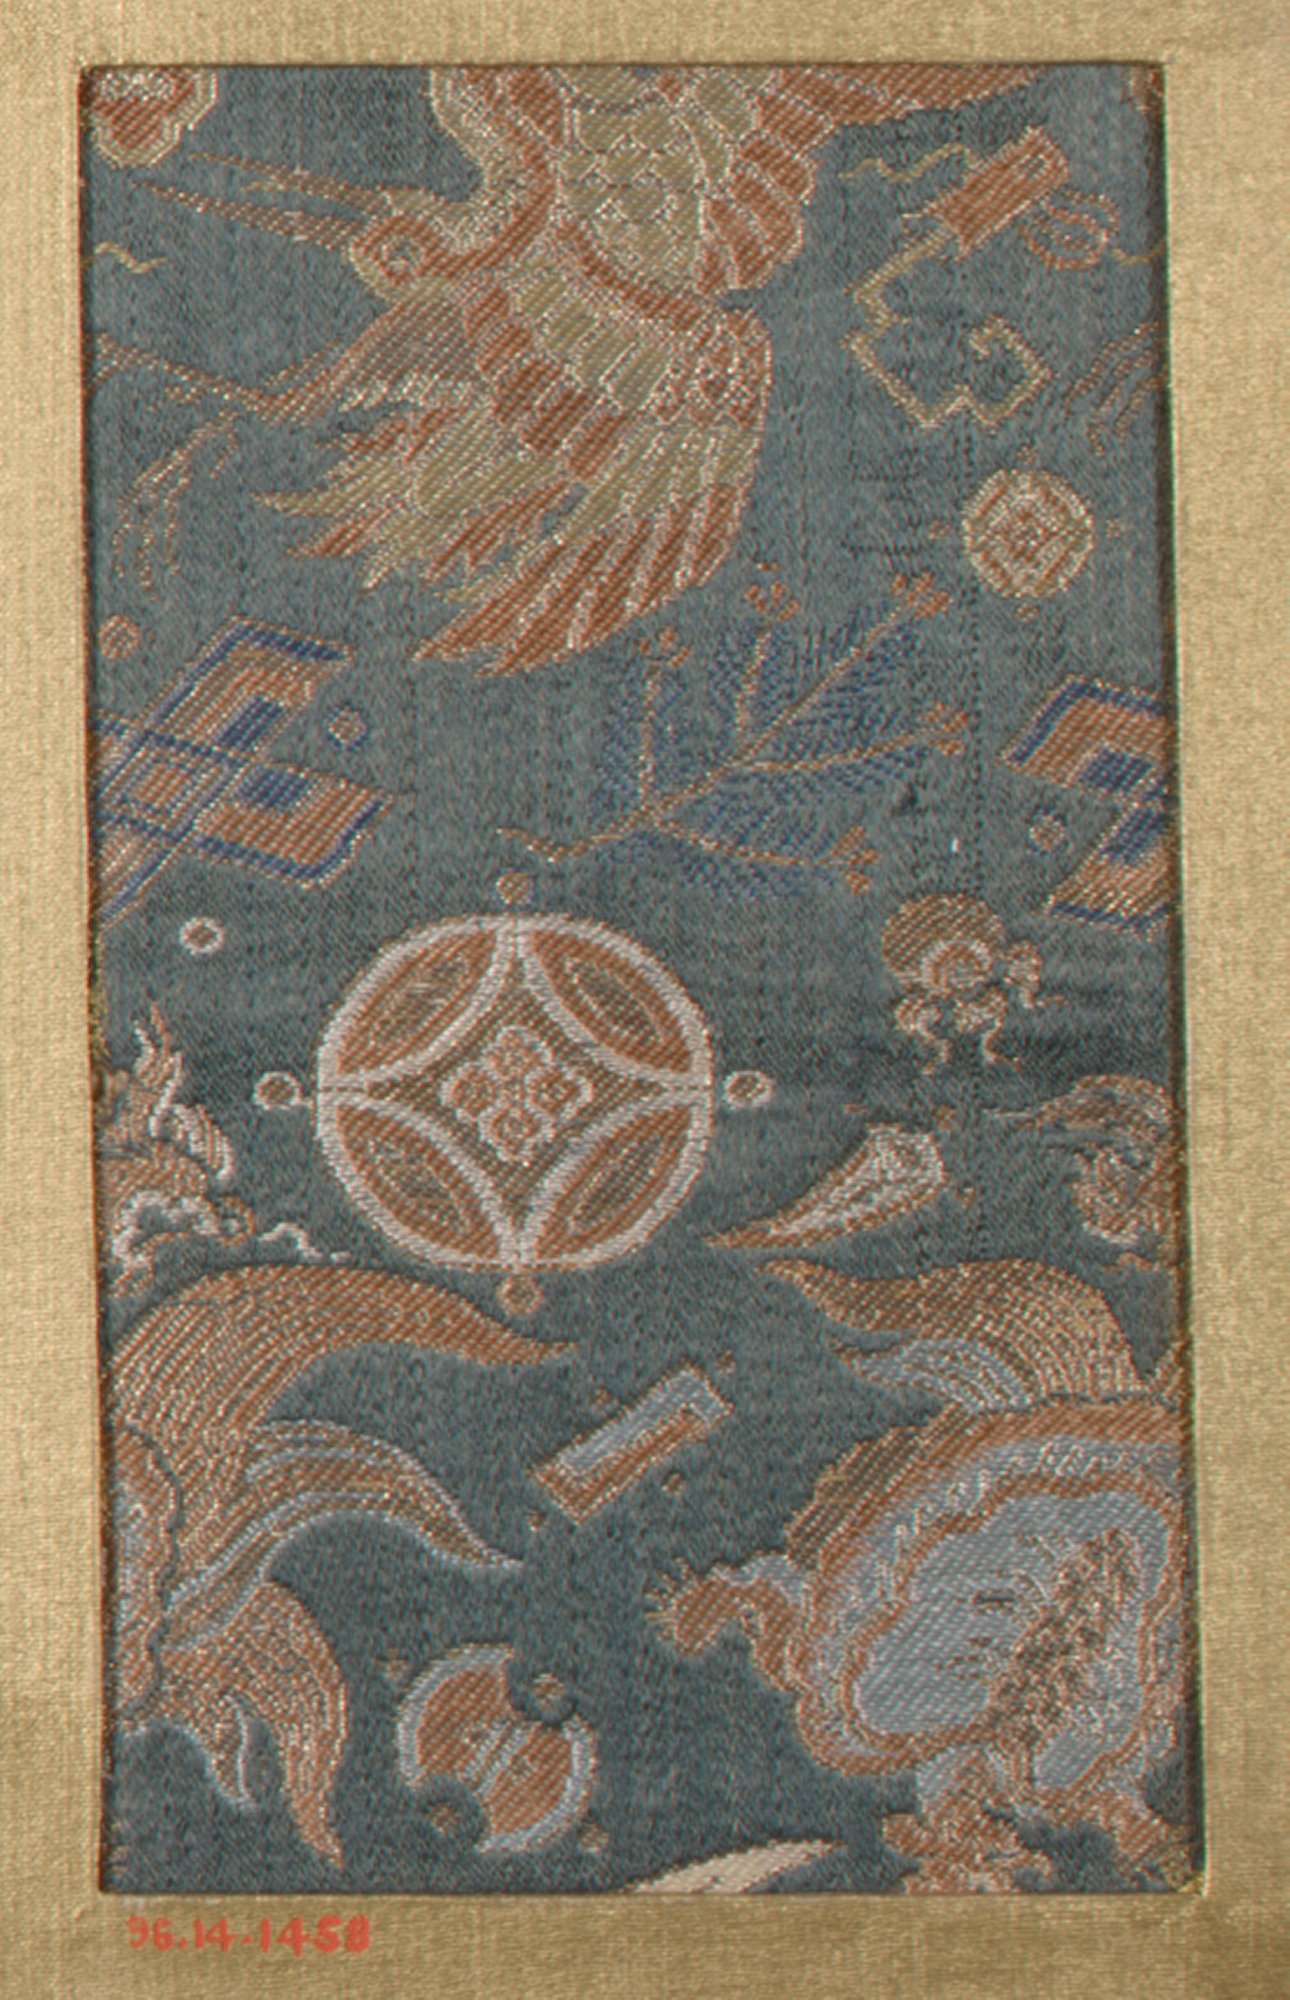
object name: piece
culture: japanese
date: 1701-1900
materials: silk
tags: cranes,turtles